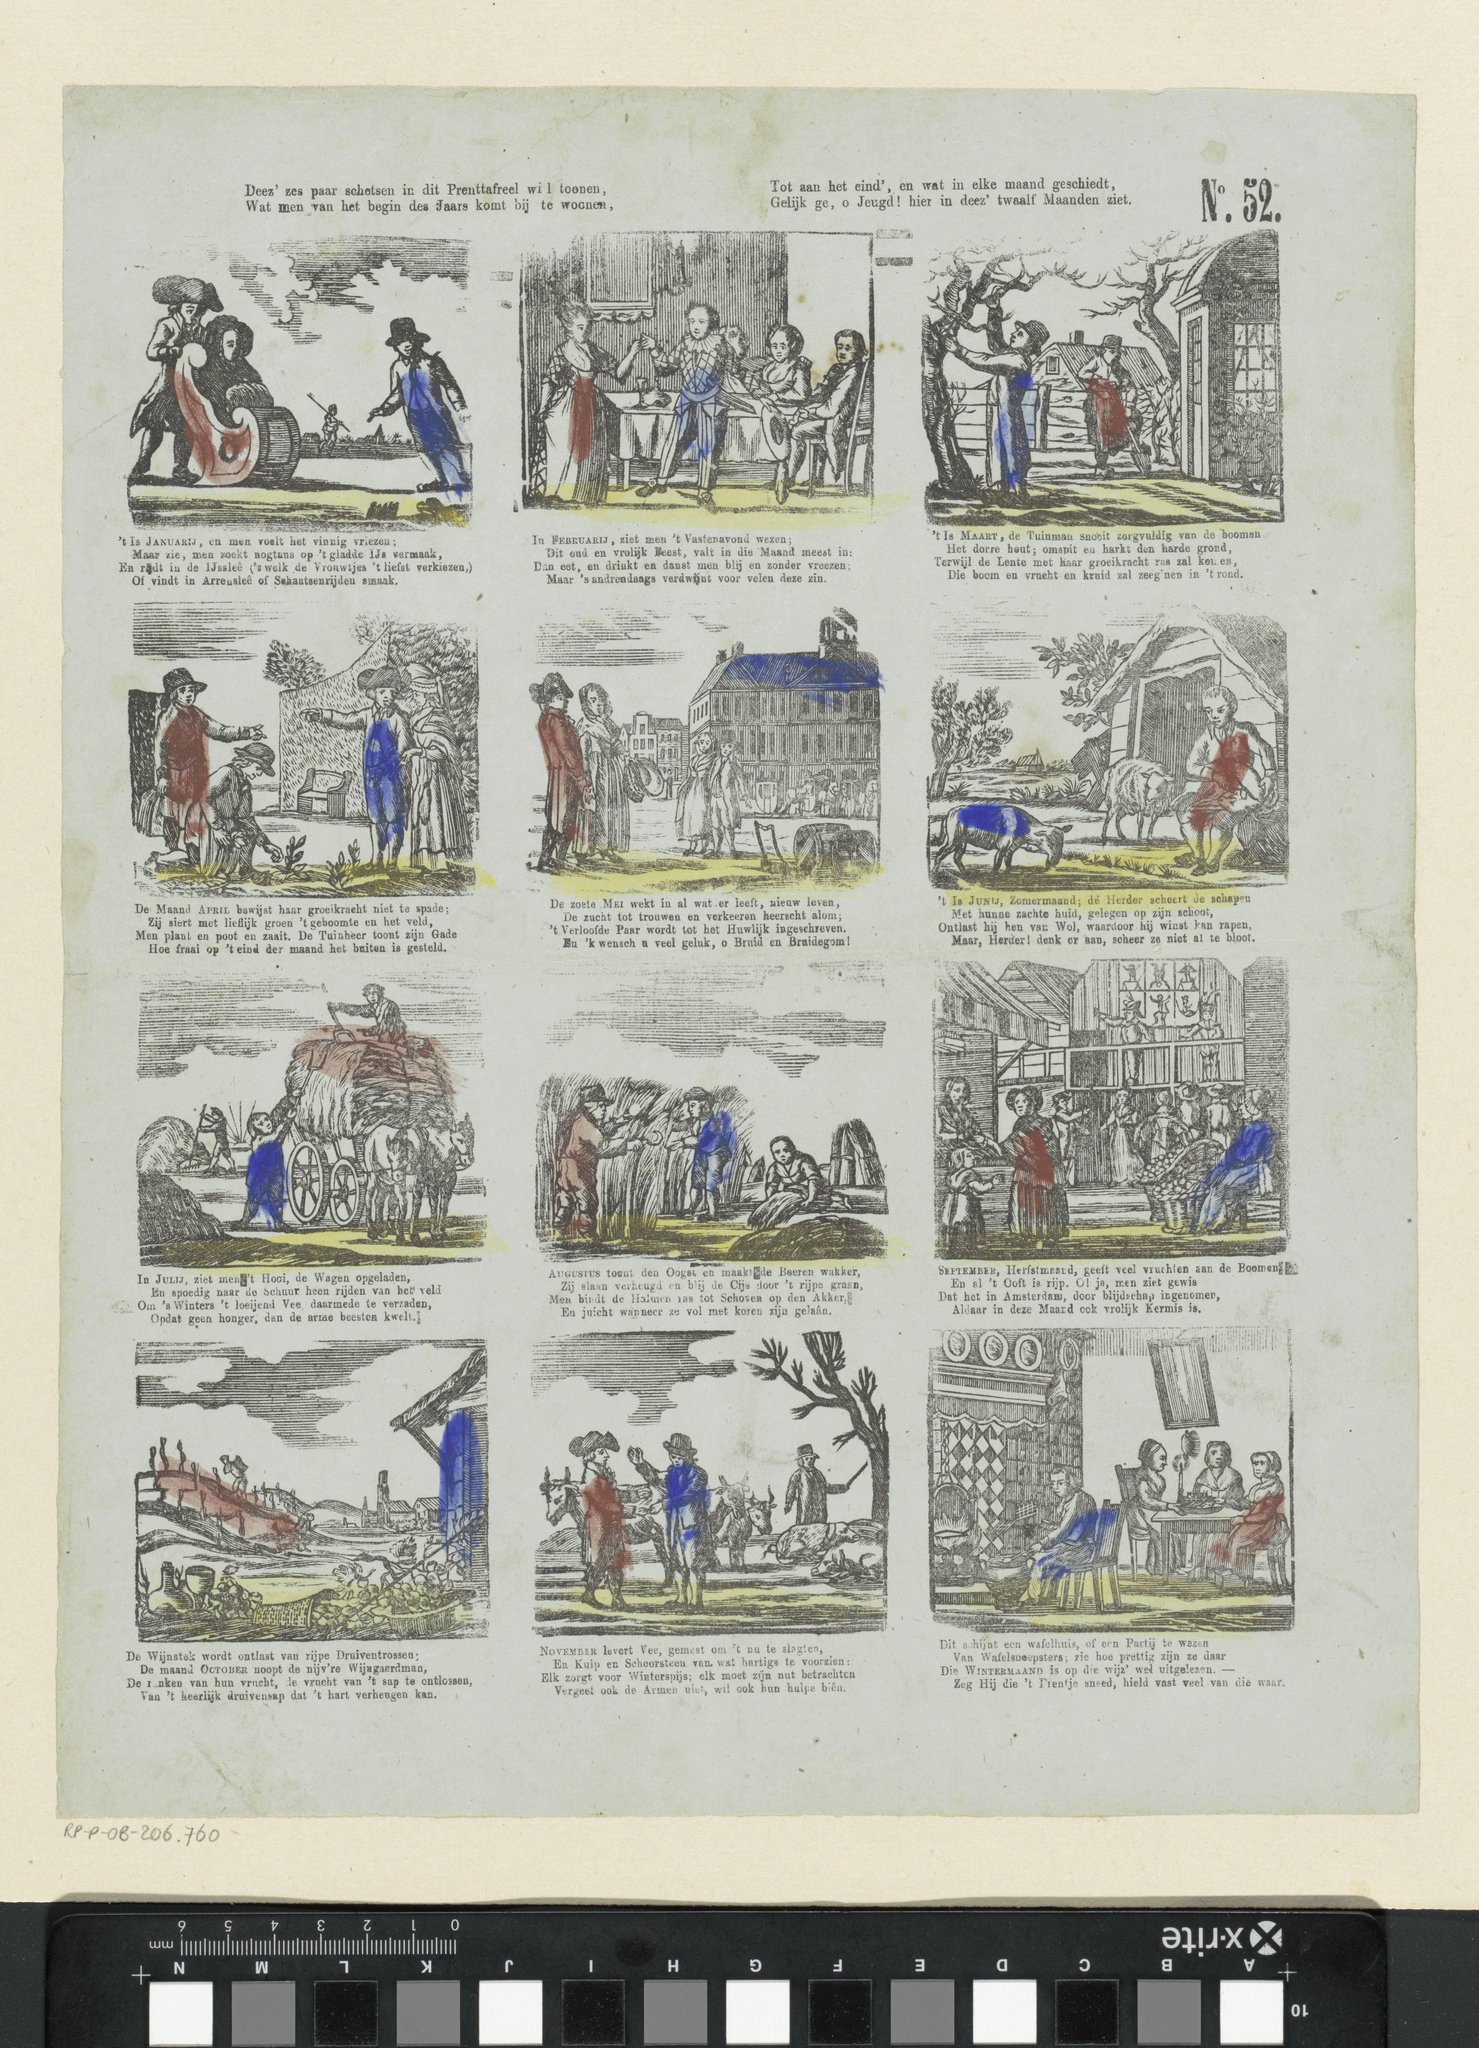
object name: popular print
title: Deez' zes paar schetsen in dit prenttafreel wil toonen, / Wat men van het begin des jaars komt bij te woonen, / Tot aan het eind', en wat in elke maand geschiedt, / Gelijk ge, o jeugd! hier in deez' twaalf maanden ziet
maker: Anonymous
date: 1850-1870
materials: paper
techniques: colour, letterpress printing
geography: netherlands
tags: the twelve months represented by scenes showing human activities, usually in a landscape; so-called 'labours of the months'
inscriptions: collector's mark: Lugt 2760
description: Blad met 12 voorstellingen van de twaalf maanden van het jaar en bijbehorende activiteiten. Onder elke afbeelding een onderschrift. Genummerd rechtsboven: No. 52.